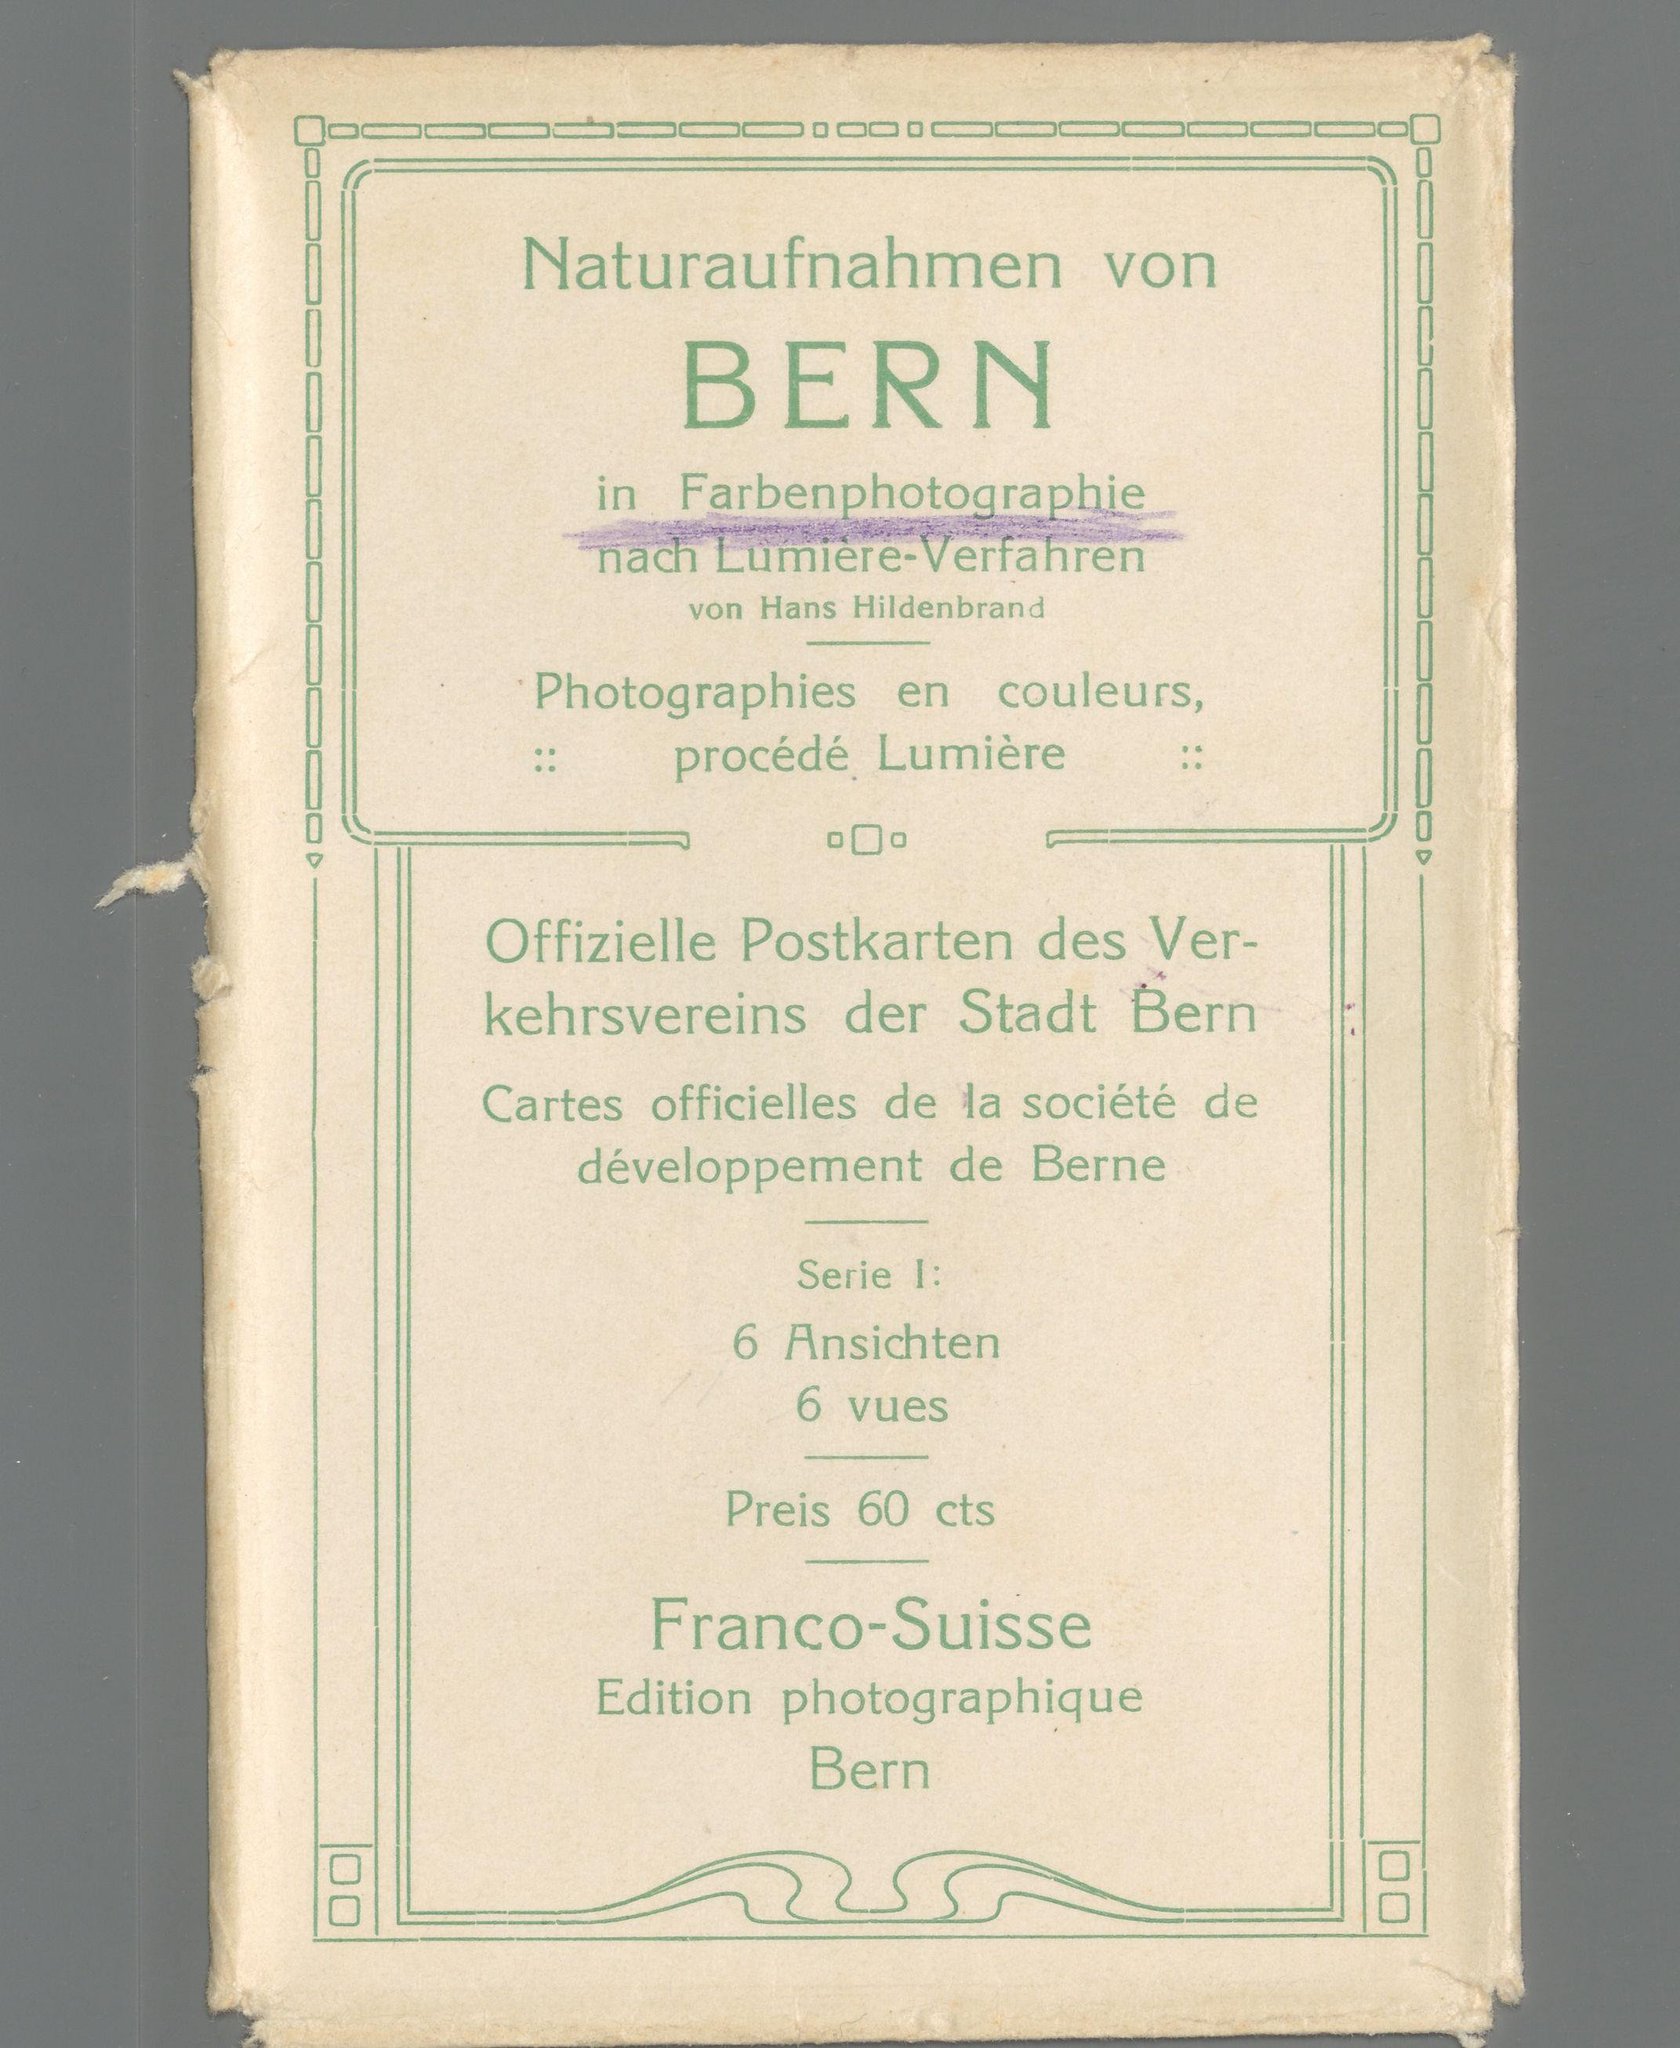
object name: wrapper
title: Naturaufnahmen von Bern in Farbenphotographie nach Lumière-Verfahren / Photographies en couleurs, procédé Lumière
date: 1909-1930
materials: paper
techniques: letterpress printing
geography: bern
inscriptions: stamp: ‘Carl Marz, Bern. Marktgasse 50. Buch- und Kunsthandlung. Antiquariat. Kunstsalon. Telephon 3786’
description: Het omslag is bedoeld voor zes prentbriefkaarten. In dit exemplaar zijn acht prentbriefkaarten aangetroffen.